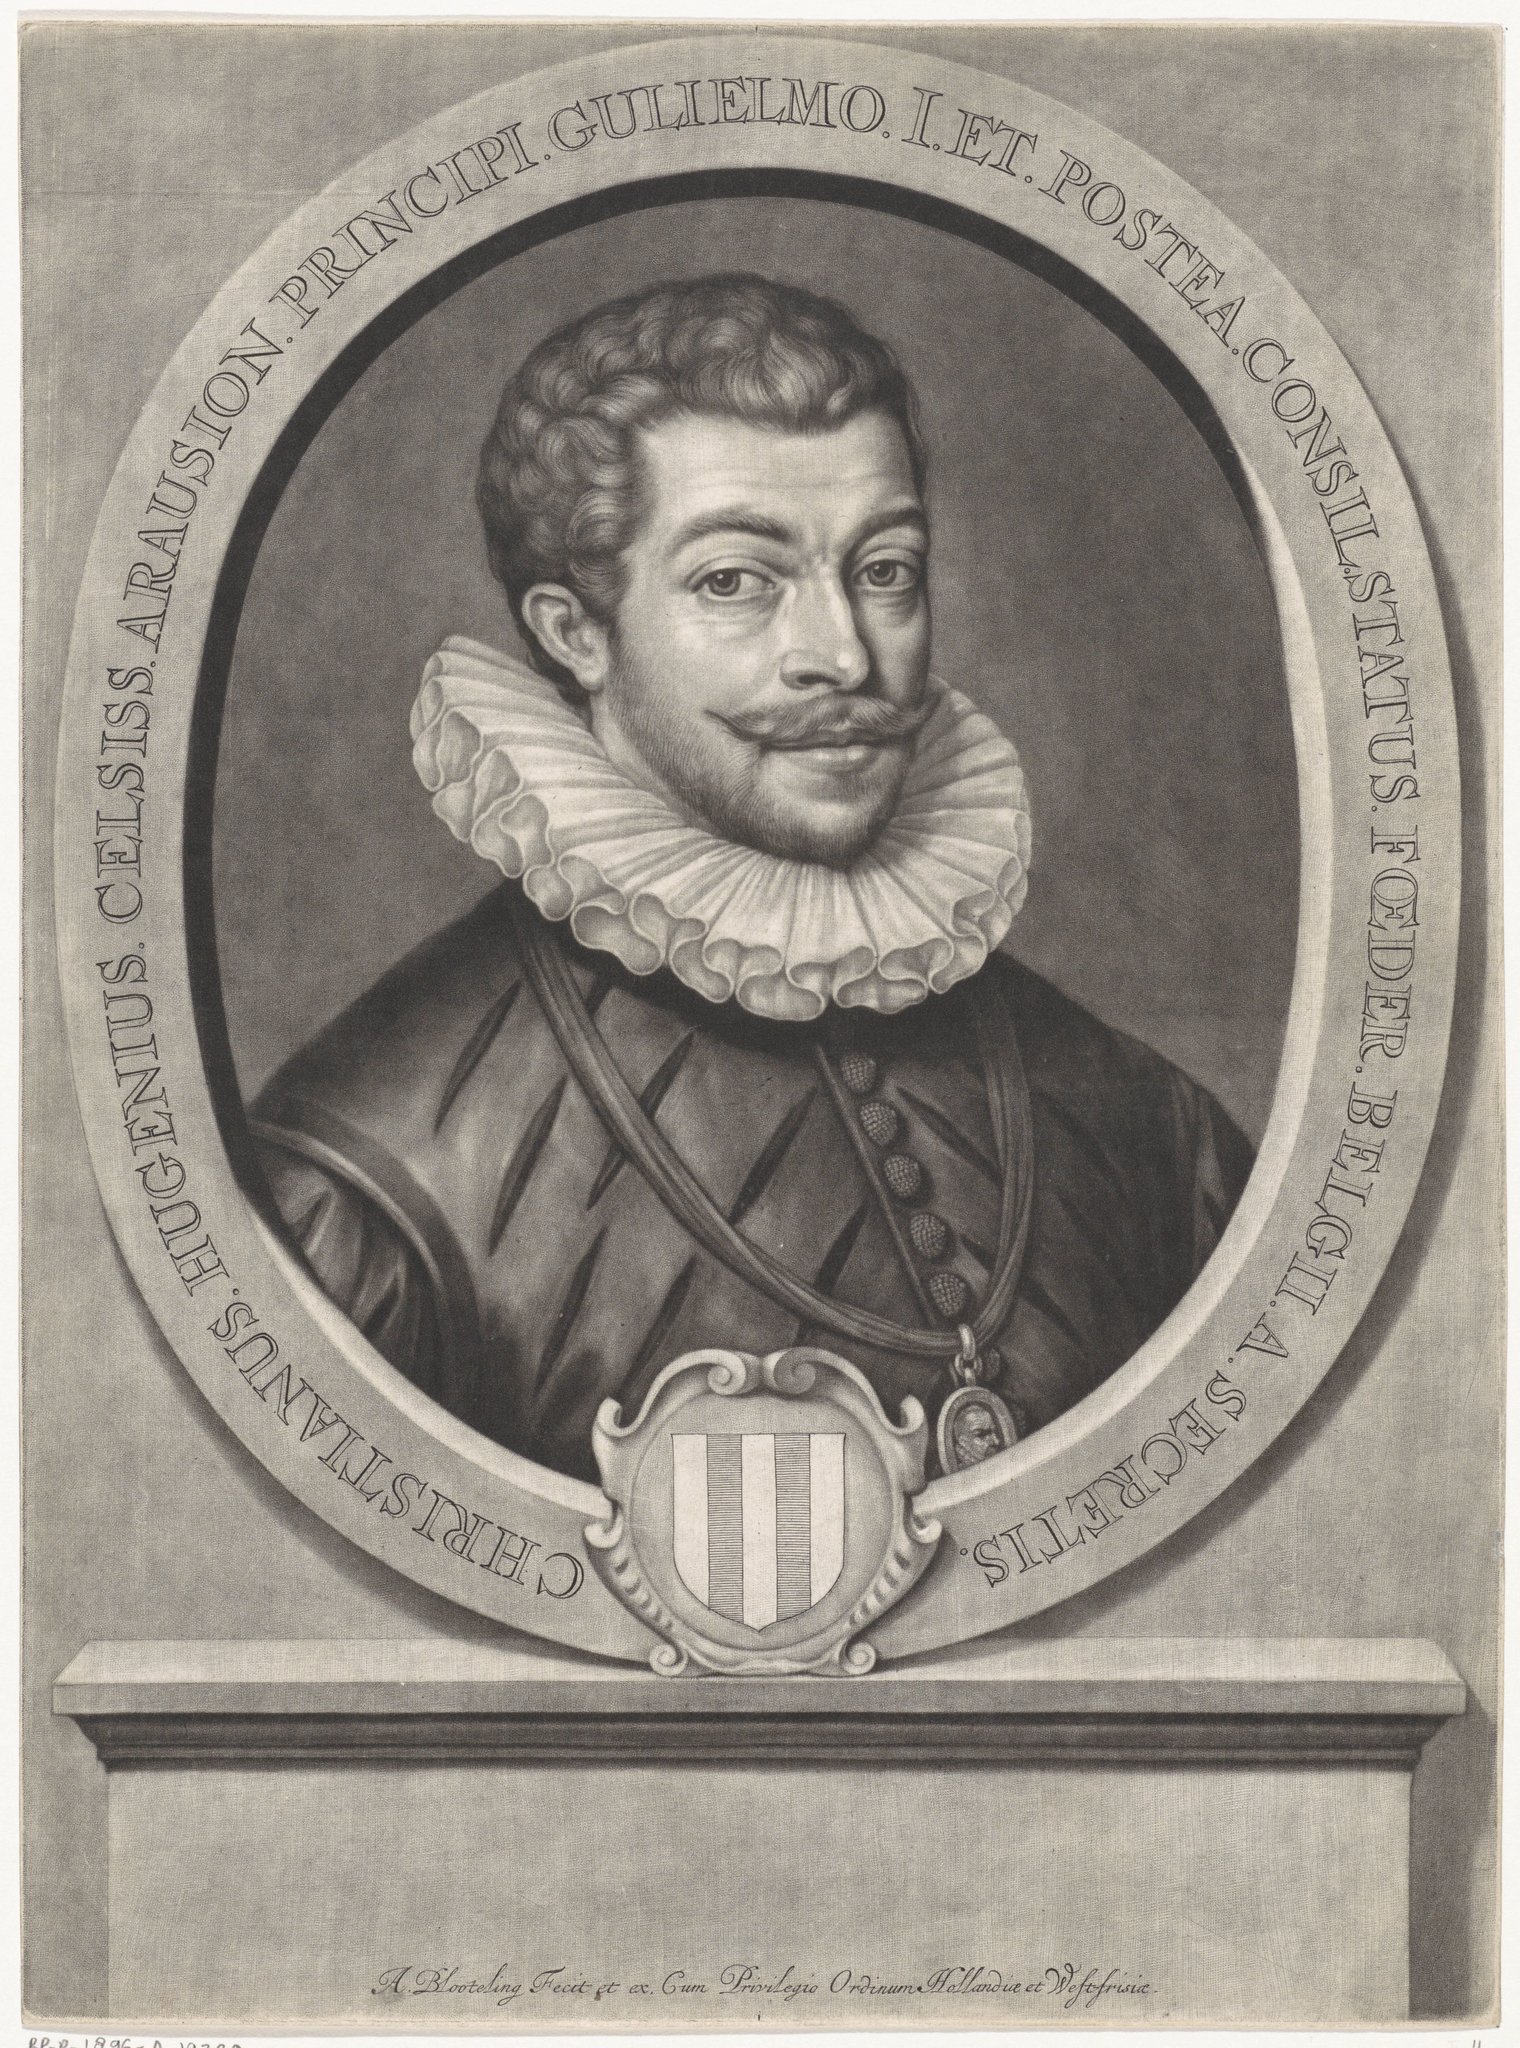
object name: print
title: Portret van Christiaan Huygens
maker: abraham bloteling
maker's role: draughtsman, print maker, publisher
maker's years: 1640-1690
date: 1672-1690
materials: paper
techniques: engraving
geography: amsterdam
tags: the hague, william i (prince of orange)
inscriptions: collector's mark: Lugt 2228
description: Portret van Christiaan Huygens, secretaris van prins Willem van Oranje (1578-1584) en Secretaris van de Raad van State (1584-1624)